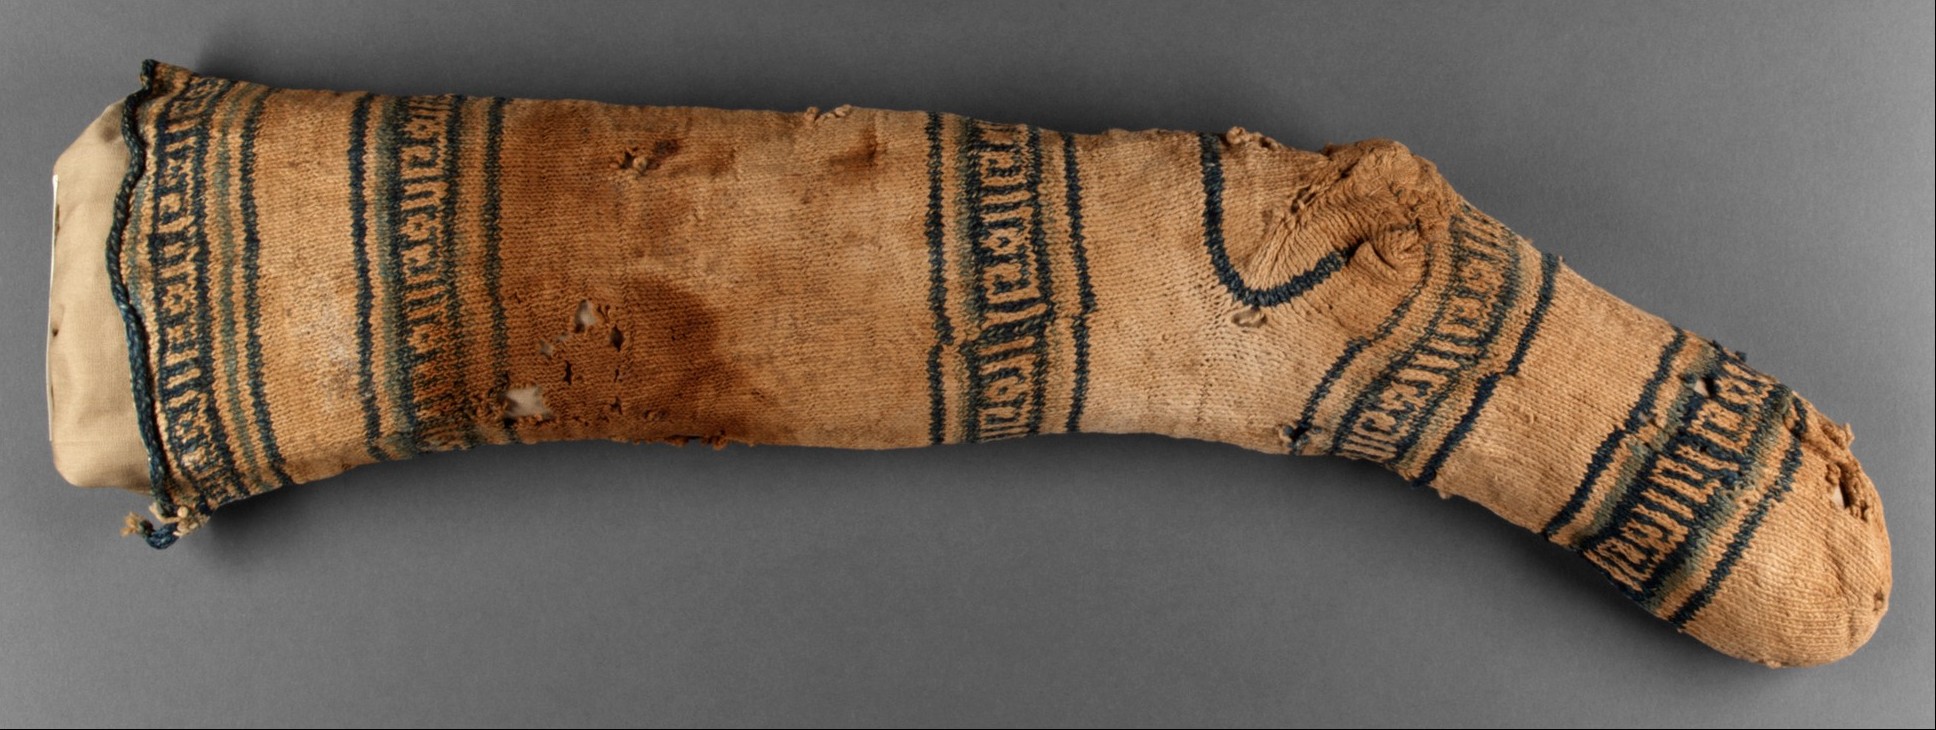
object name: sock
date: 1101-1300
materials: cotton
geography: egypt